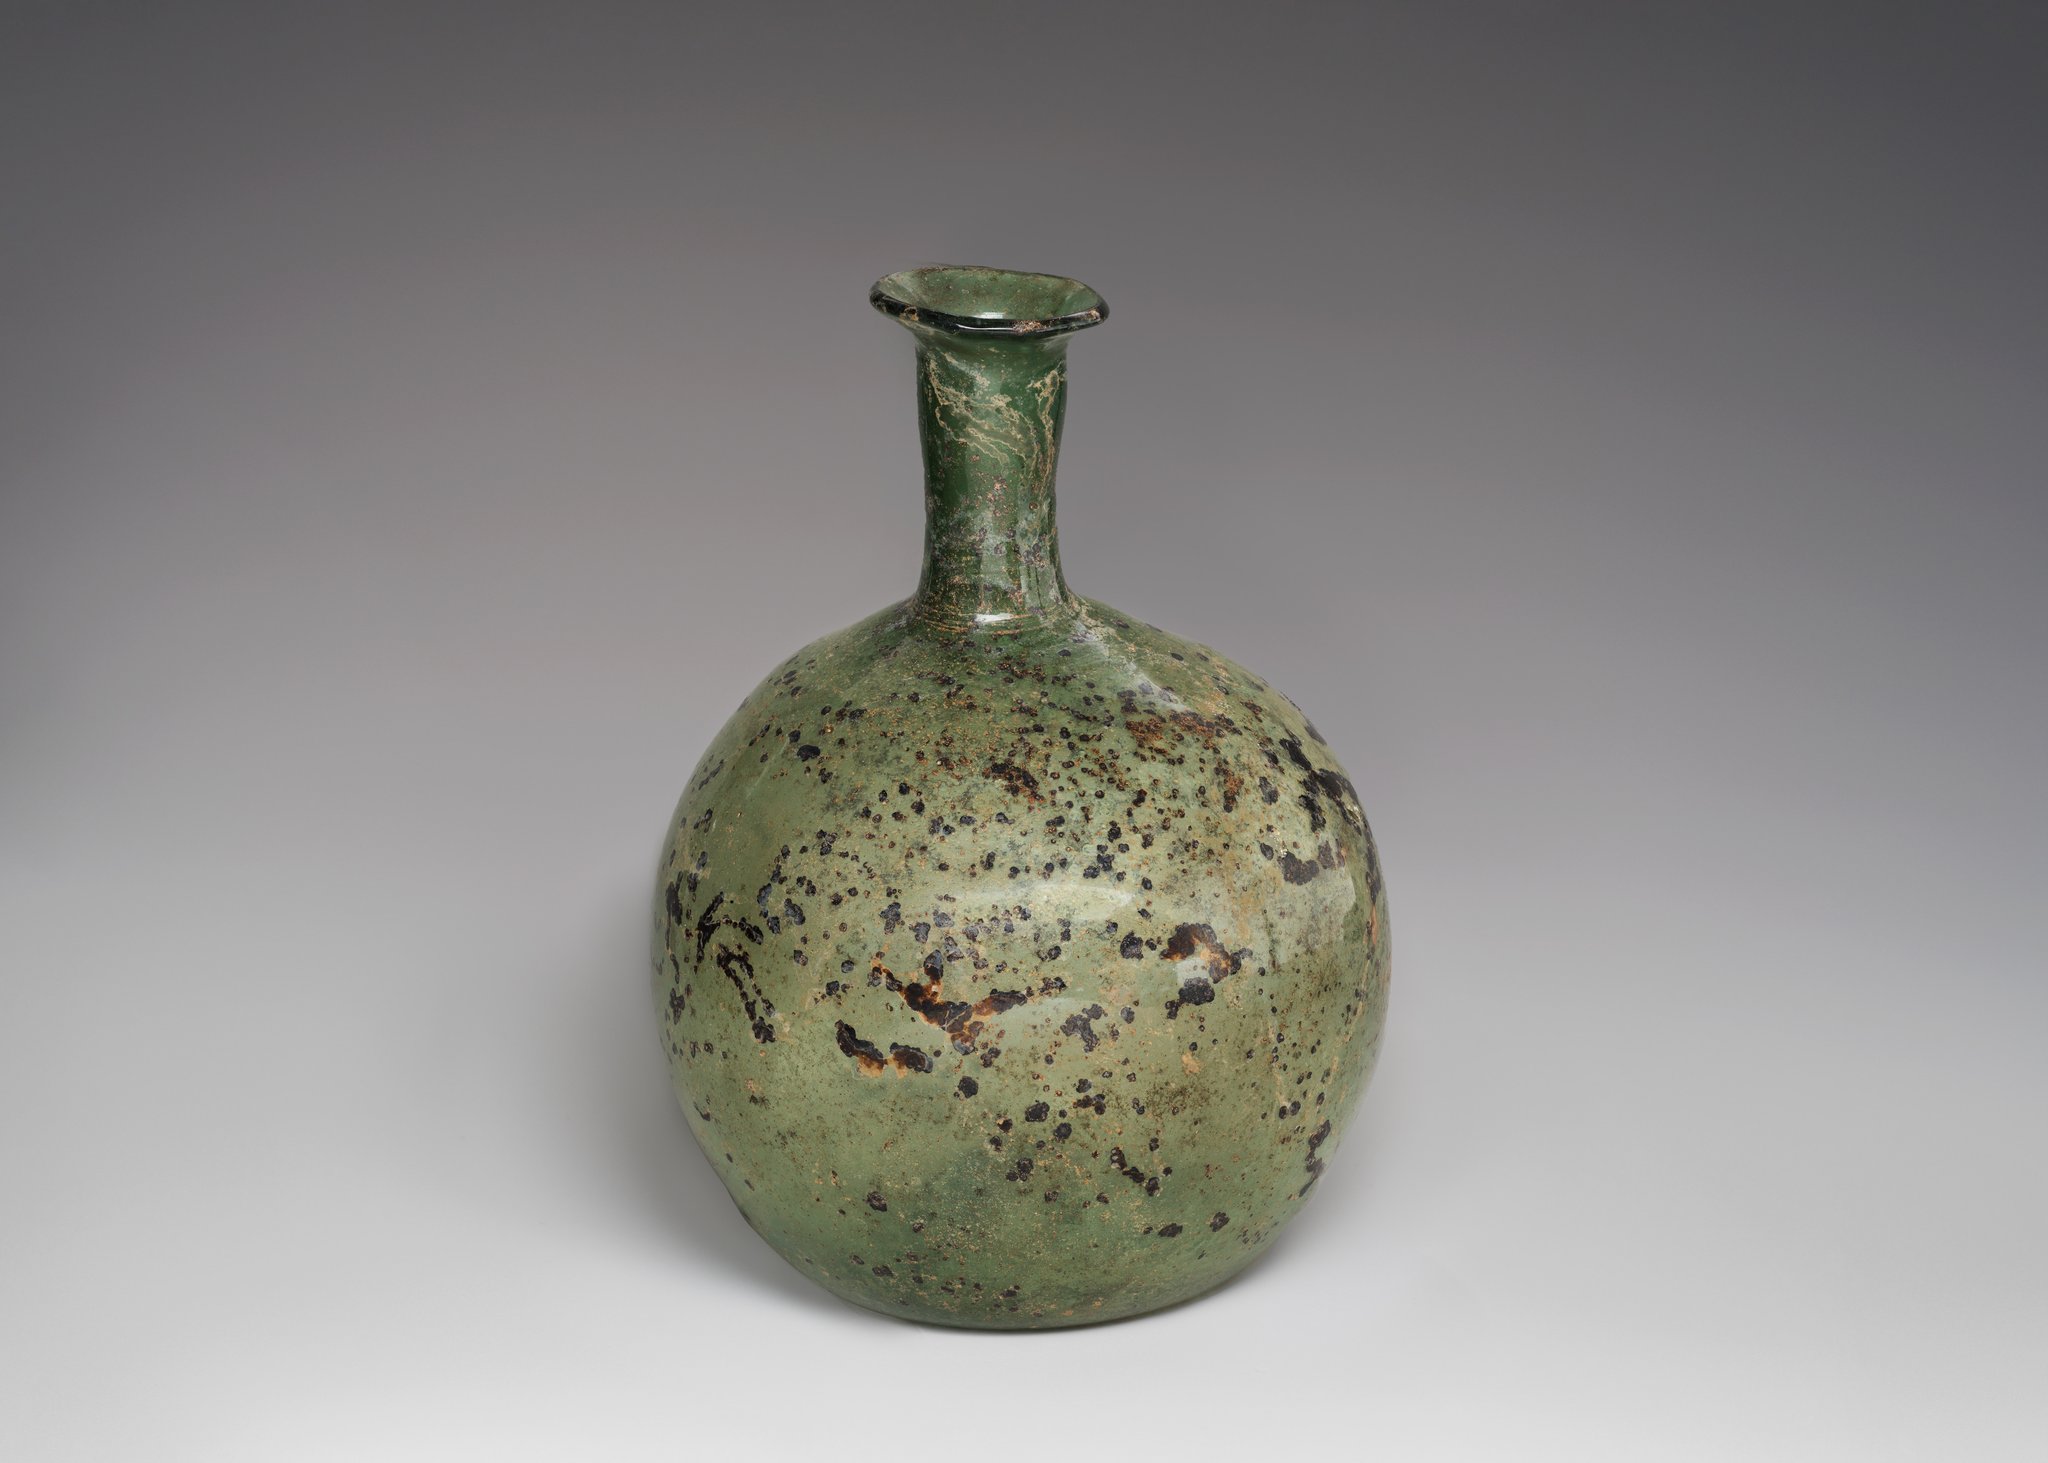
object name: bottle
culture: sasanian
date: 201-700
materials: glass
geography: iran